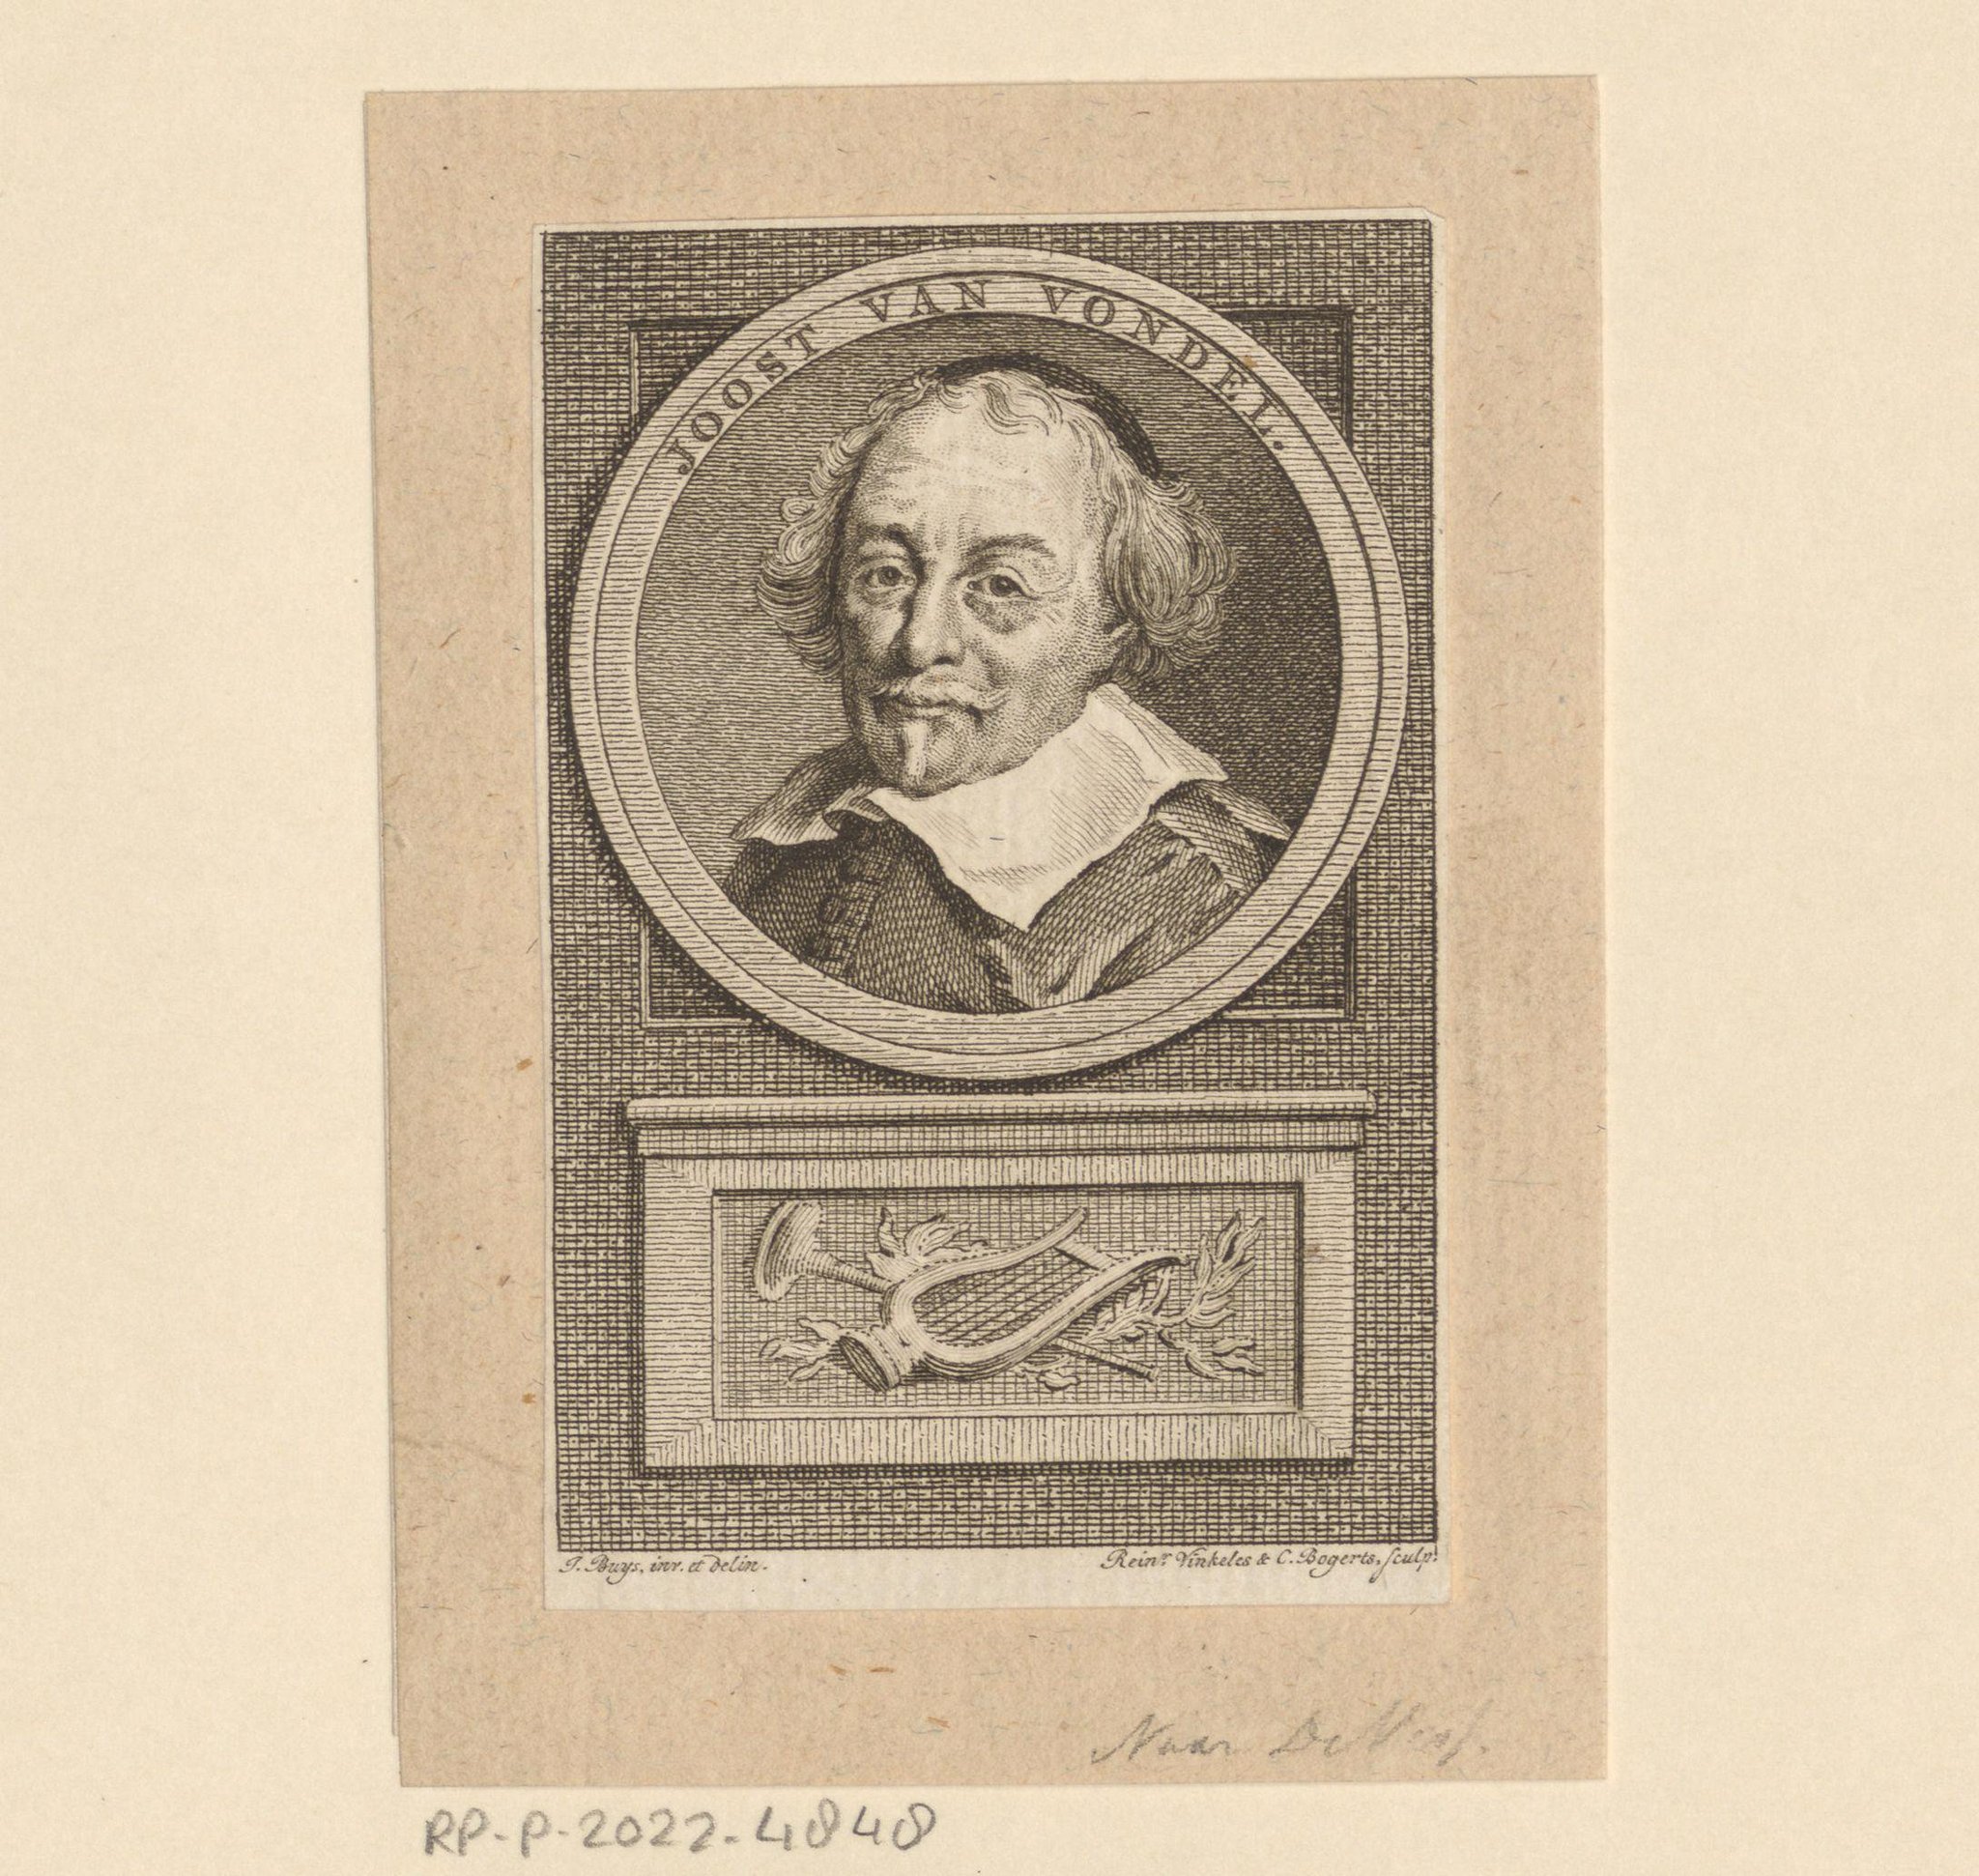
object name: print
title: Portret van Joost van den Vondel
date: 1788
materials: paper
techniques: etching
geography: northern netherlands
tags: cologne, amsterdam, joost van den vondel, historical persons, portrait of a writer, writer, poet, author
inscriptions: collector's mark: Lugt 2165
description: Prent waarschijnlijk uit: Fokke, Jan. Geschiedenissen der Vereenigde Nederlanden voor de vaderlandsche jeugd Ie-XXVste deel. Amsterdam: Johannes Allart, 1788, dl. 10.